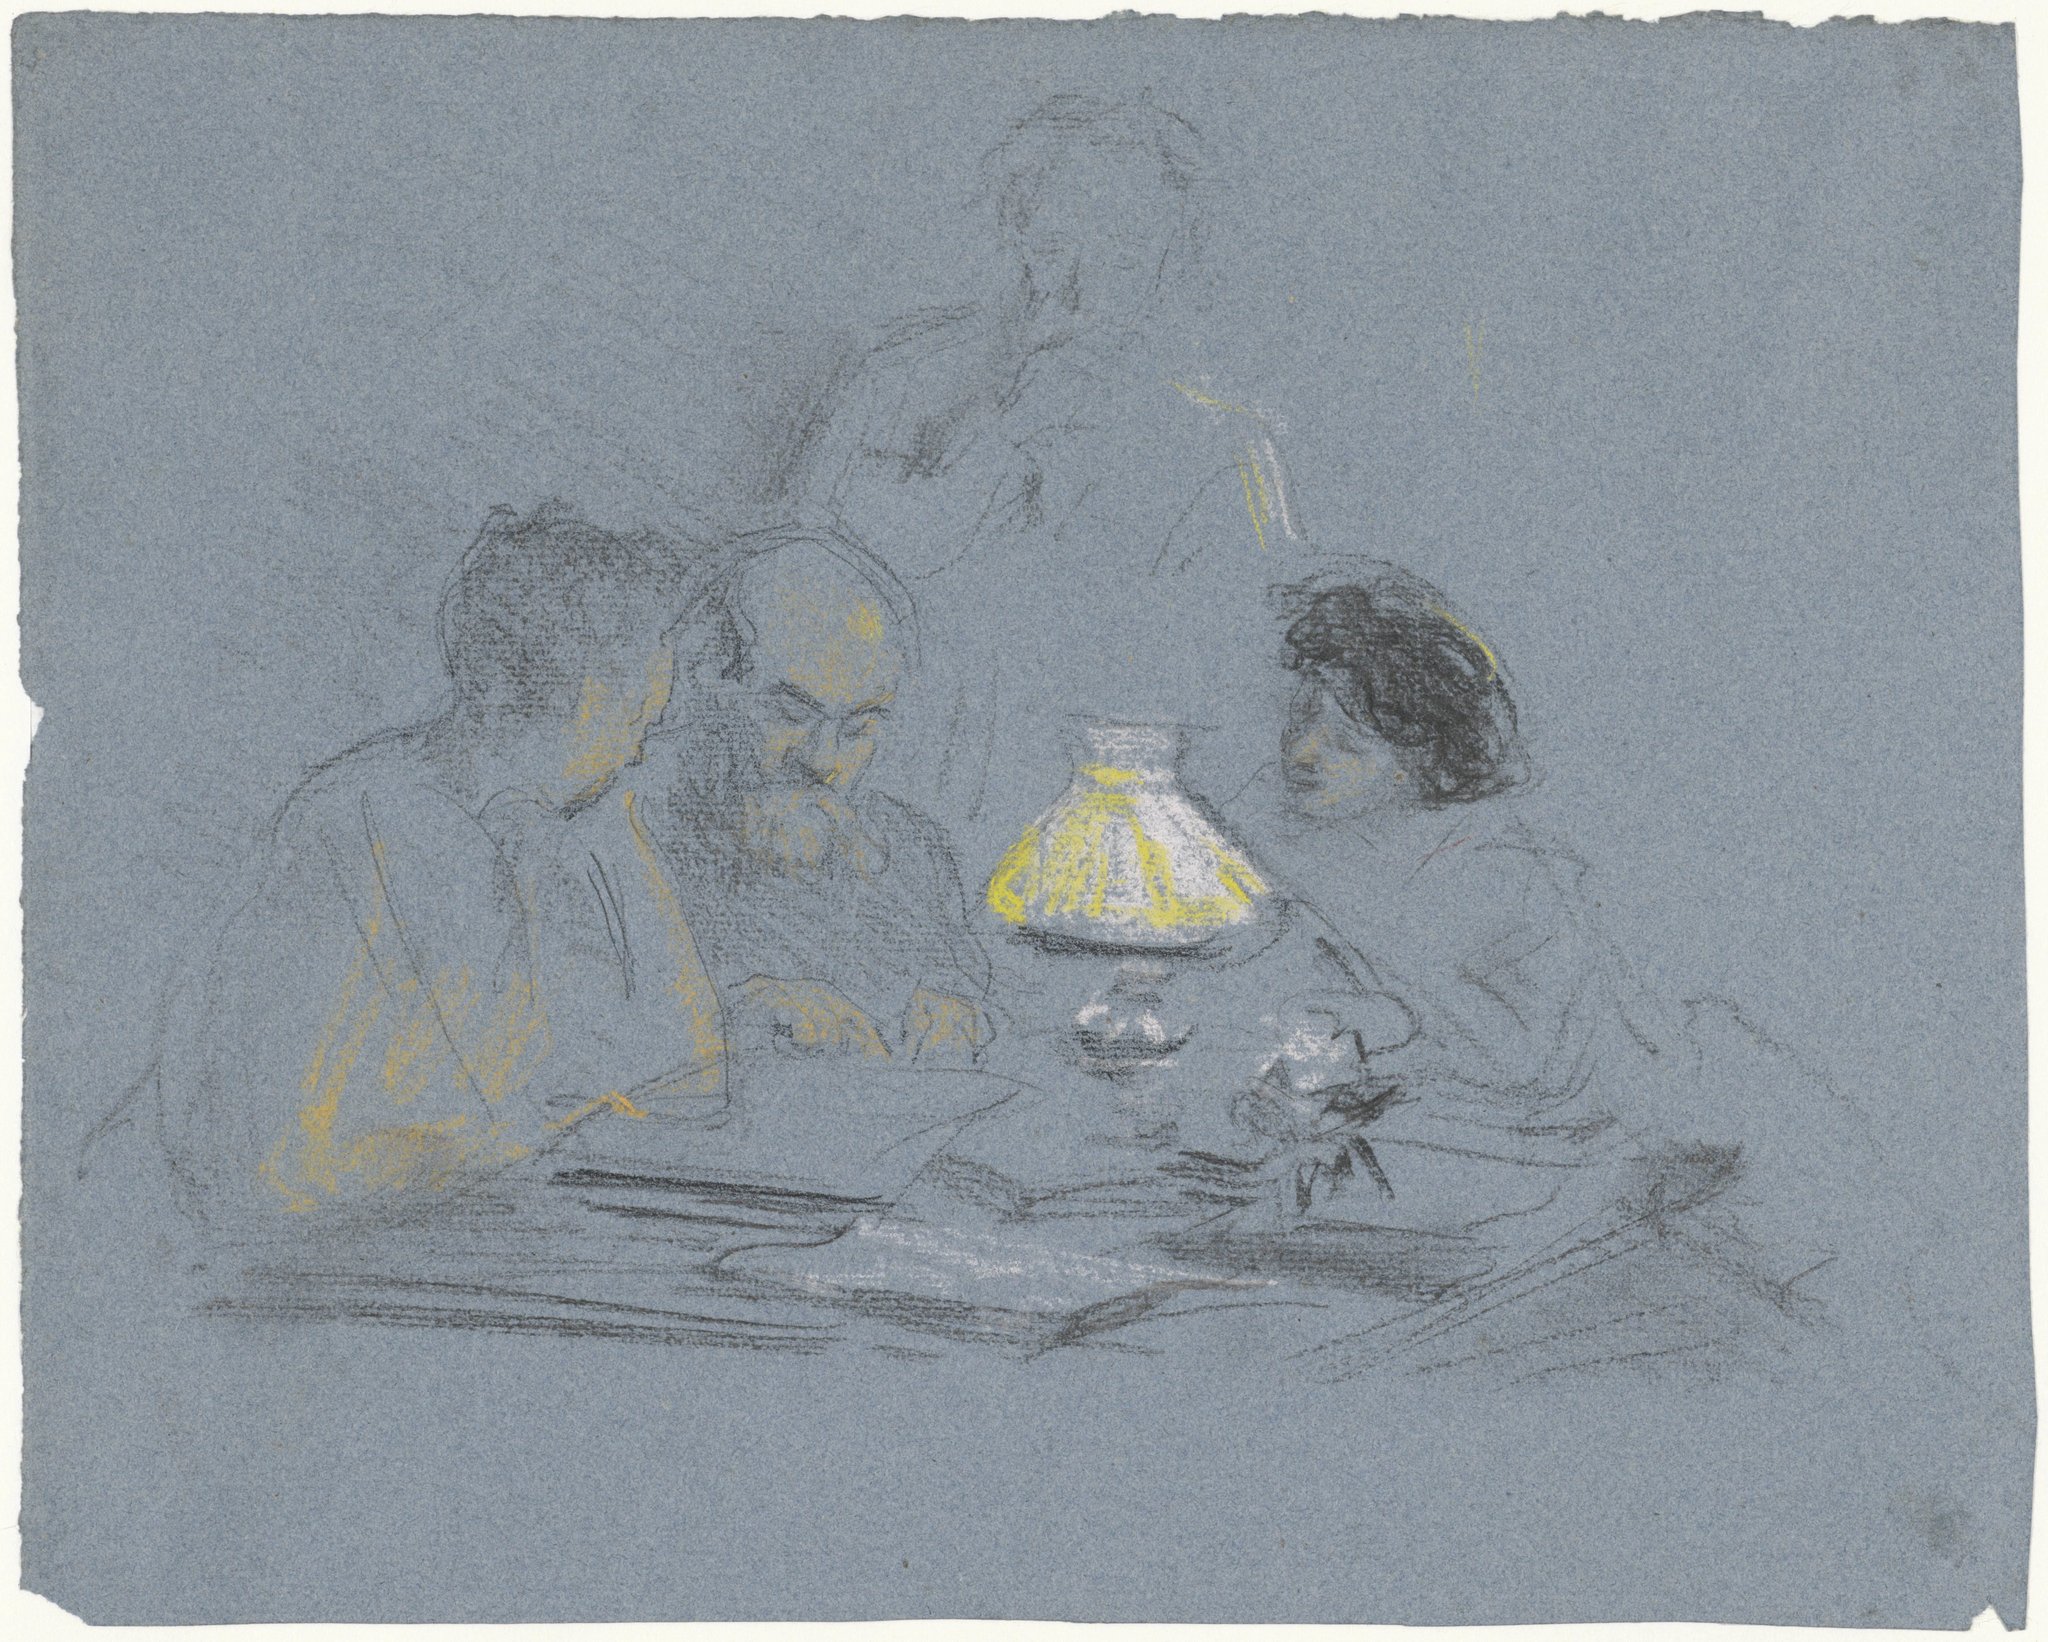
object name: drawing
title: A. Grandmont en drie figuren, lezend bij lamplicht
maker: a.a.l. de grammont-hubrecht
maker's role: draughtsman, painter, print maker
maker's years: 1855-1913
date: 1865-1913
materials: chalk, paper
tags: reading, historical persons